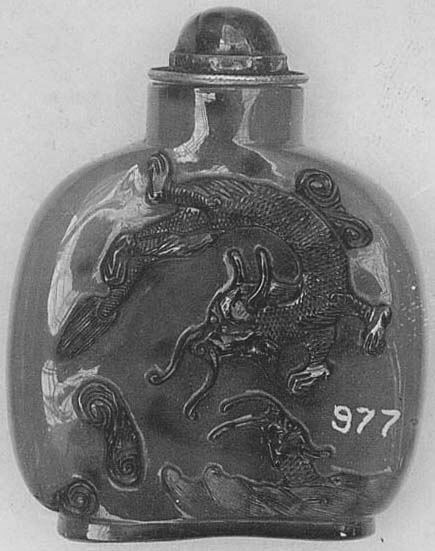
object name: snuff bottle with stopper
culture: chinese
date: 1701-1900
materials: stone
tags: dragons